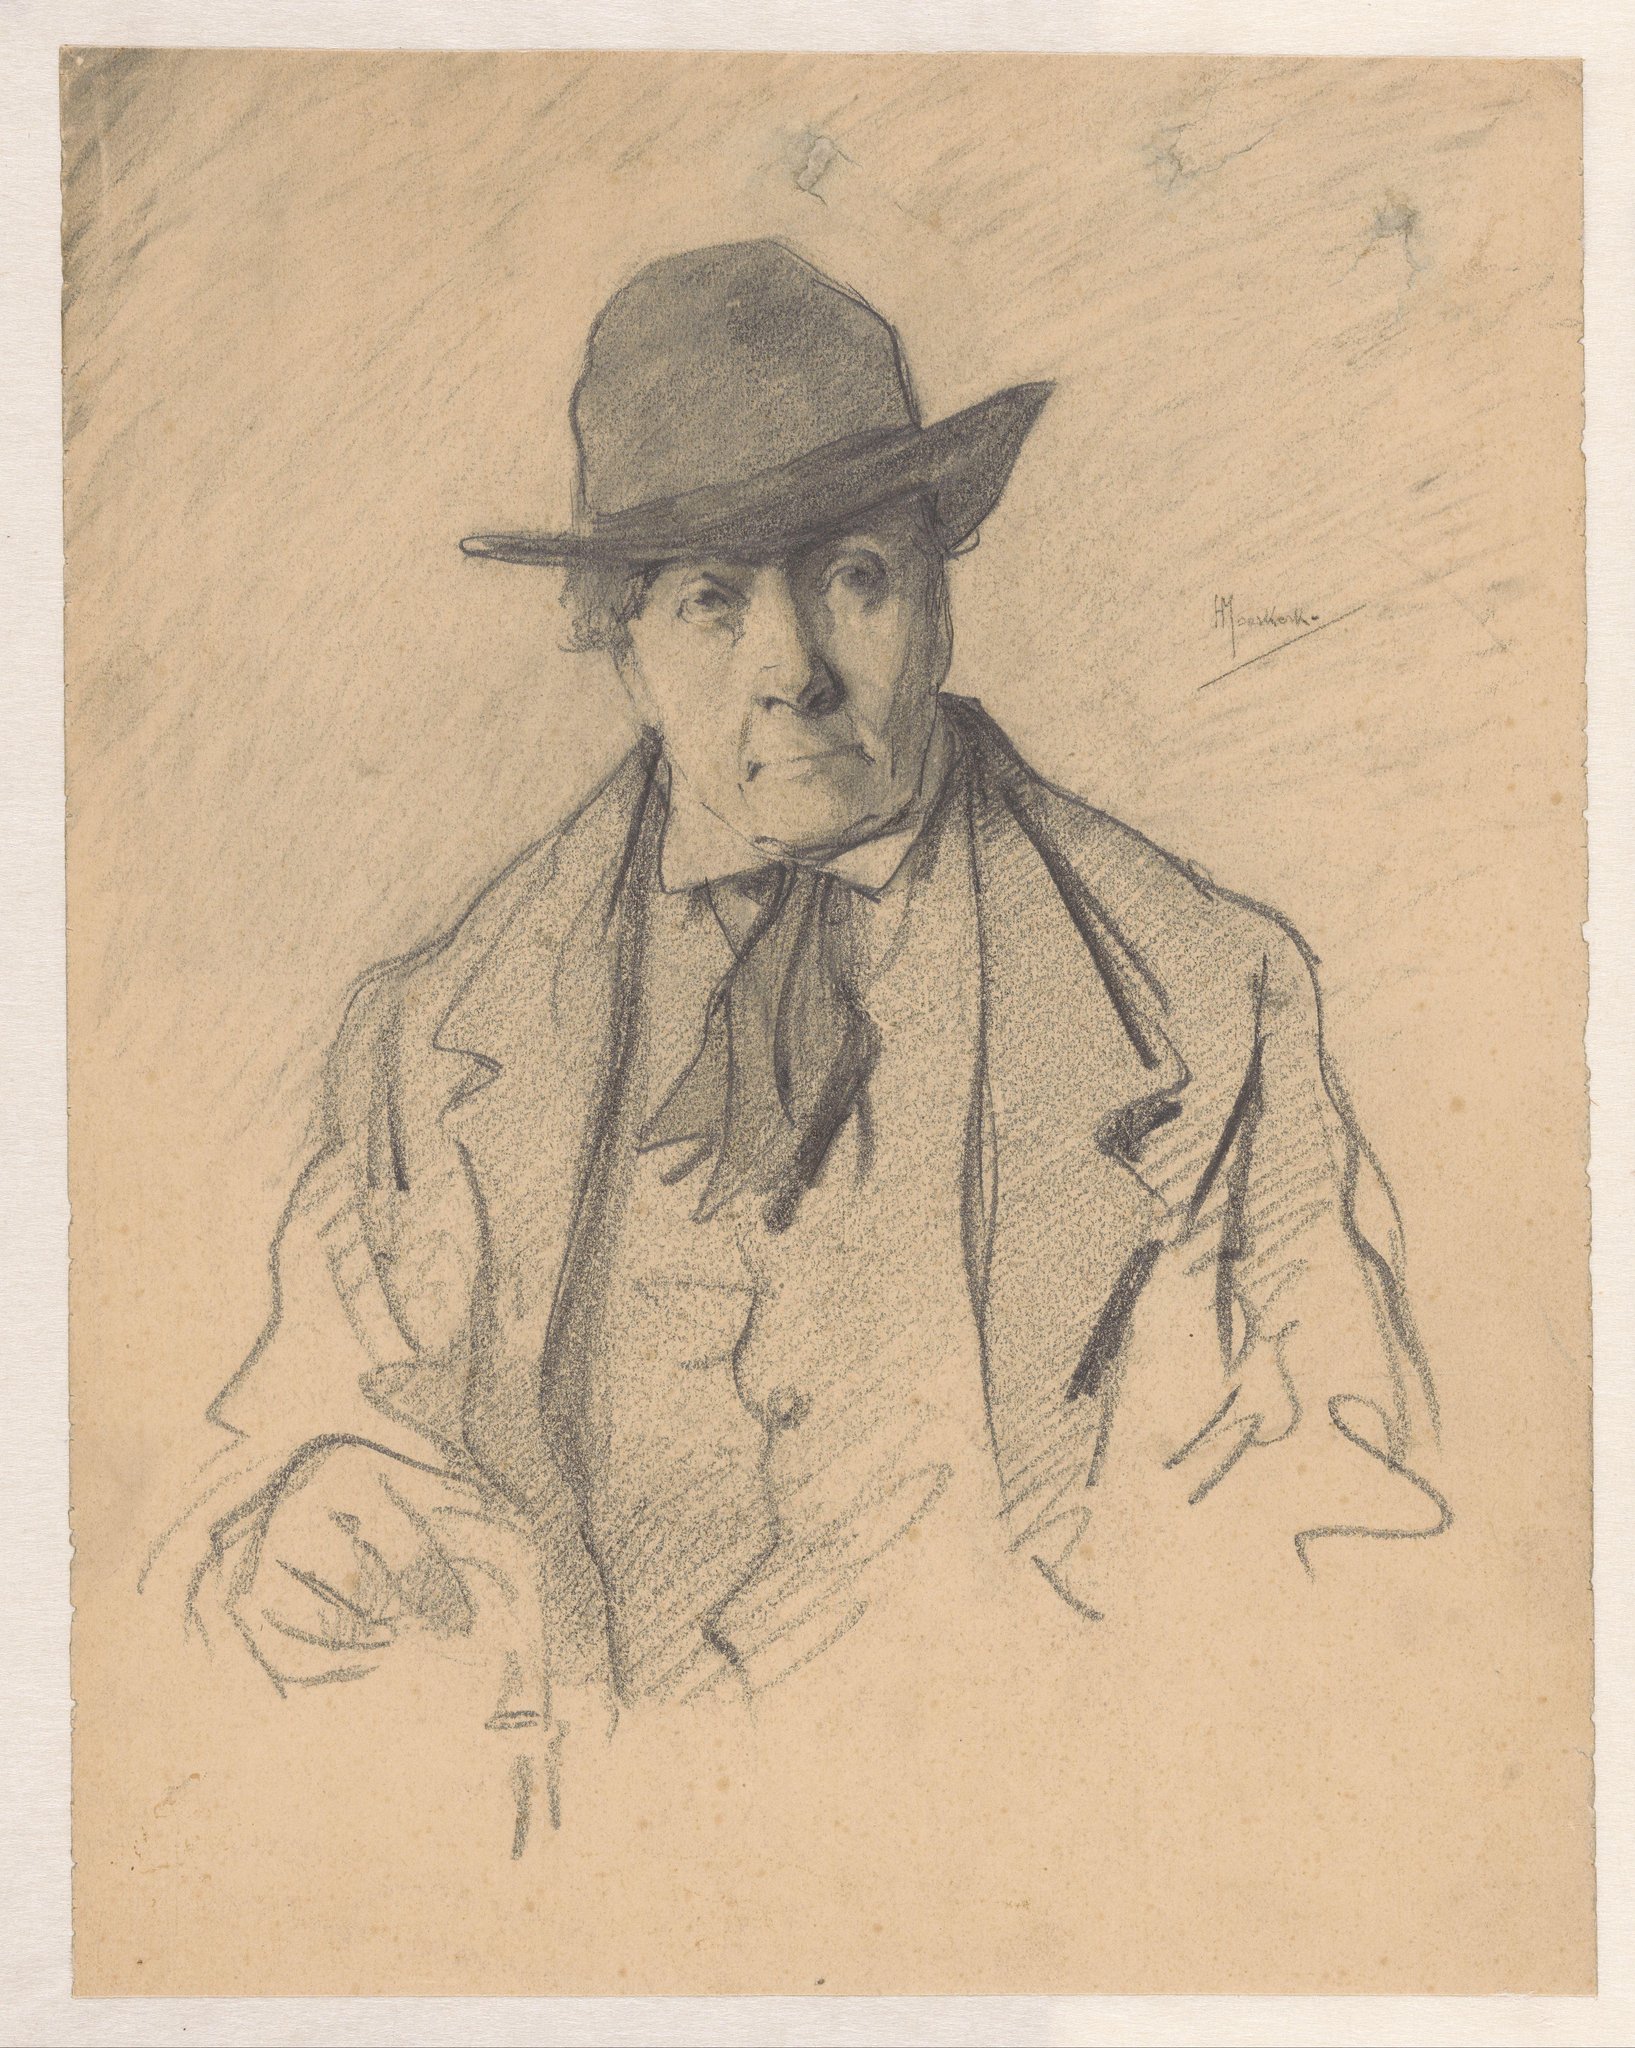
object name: drawing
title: Zelfportret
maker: herman moerkerk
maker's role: draughtsman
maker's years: 1879-1949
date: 1889-1949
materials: paper, pencil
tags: den bosch, haarlem, herman moerkerk, historical persons, portrait, self-portrait of painter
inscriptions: collector's mark: Lugt 2228, collector's mark: Lugt 2760